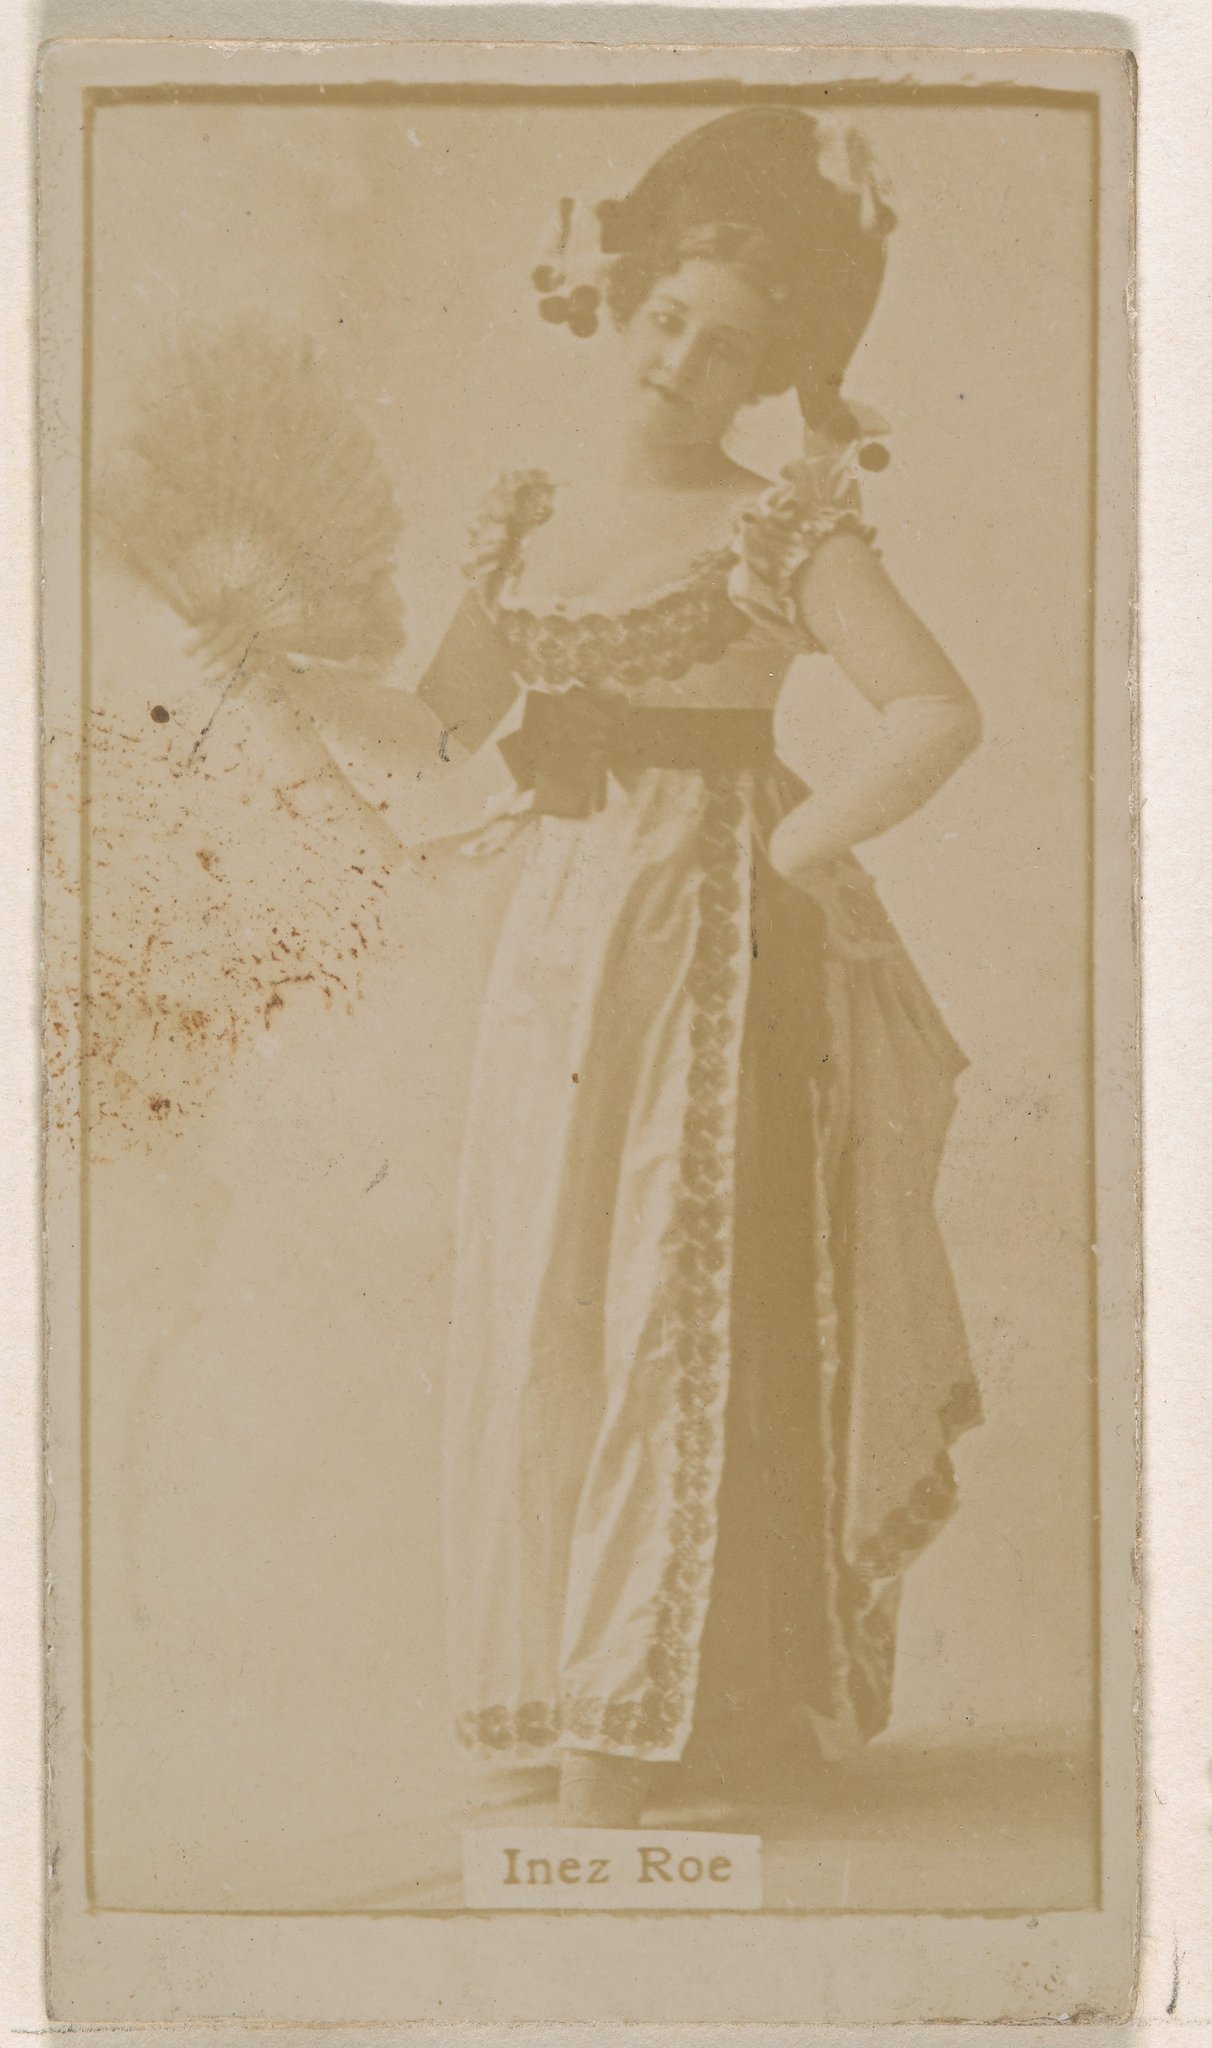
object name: photograph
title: Inez Roe, from the Actresses series (N245) issued by Kinney Brothers to promote Sweet Caporal Cigarettes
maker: kinney brothers tobacco company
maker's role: publisher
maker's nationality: american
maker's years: 1869-2011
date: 1890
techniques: albumen silver print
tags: portraits,women,actresses